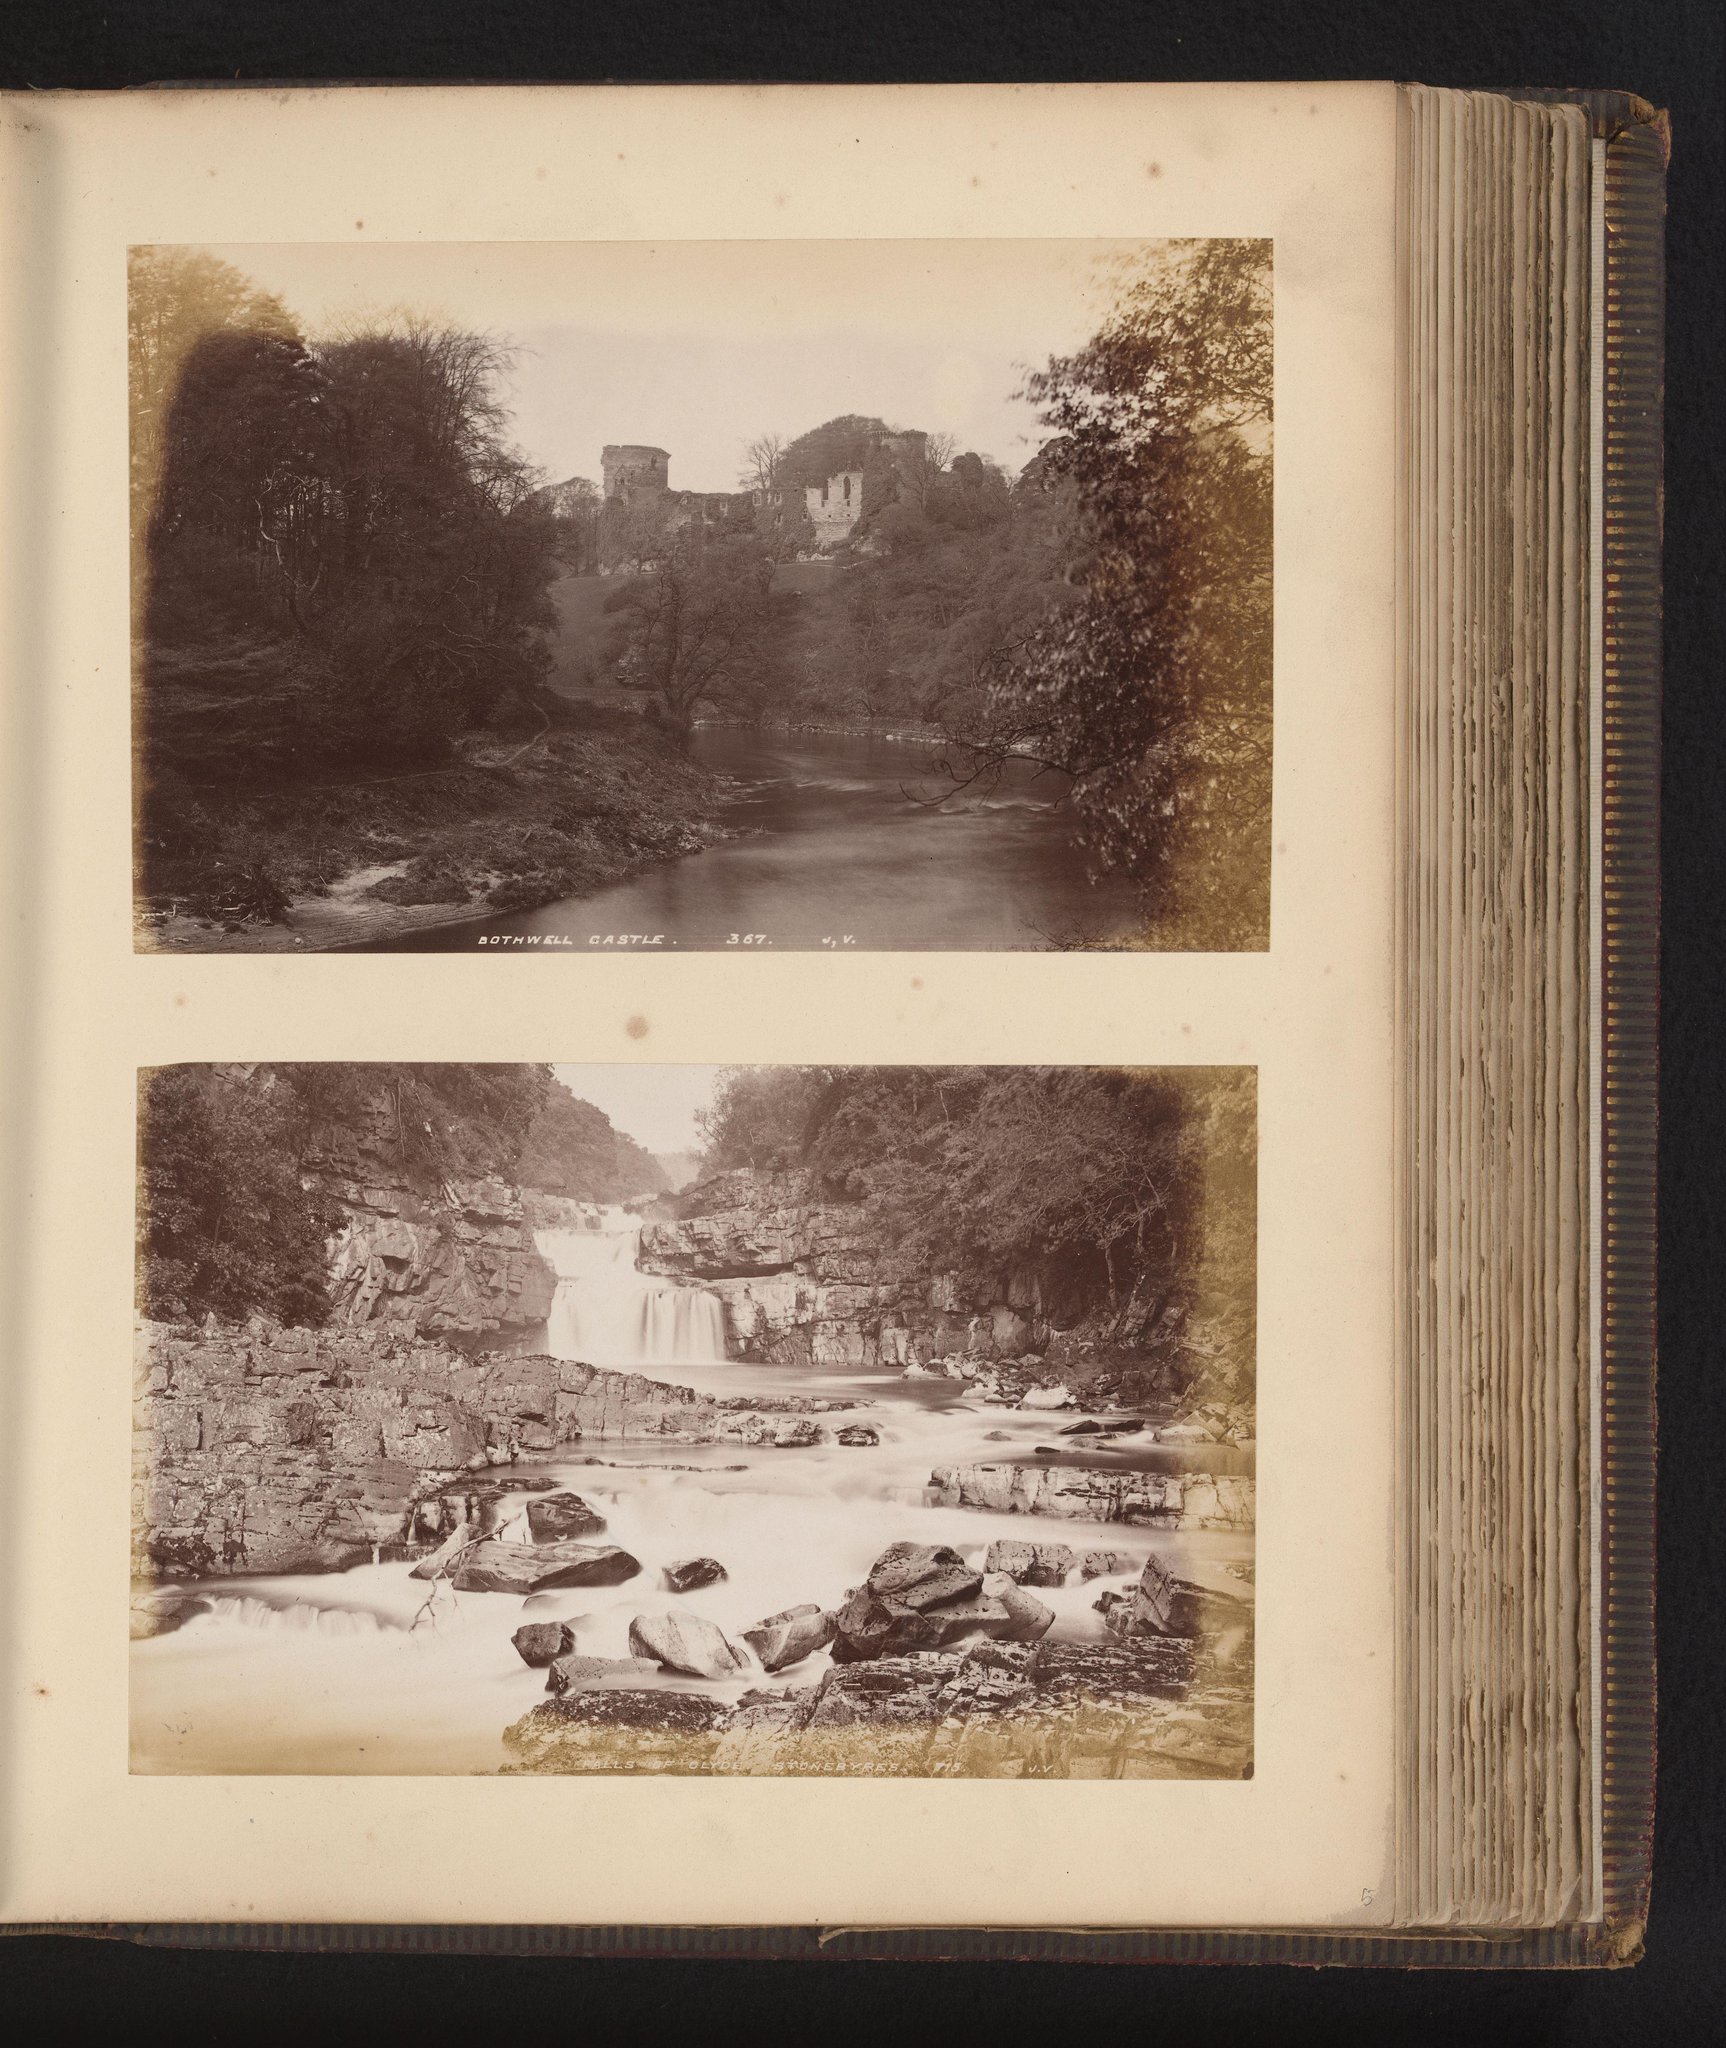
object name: photograph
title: Bothwell Castle en Gezicht op een waterval bij de Clyde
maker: Anonymous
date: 1875-1885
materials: photographic support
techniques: albumen print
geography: scotland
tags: castle, waterfall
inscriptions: number: ‘367, J.V.’, number: ‘715, J.V.’